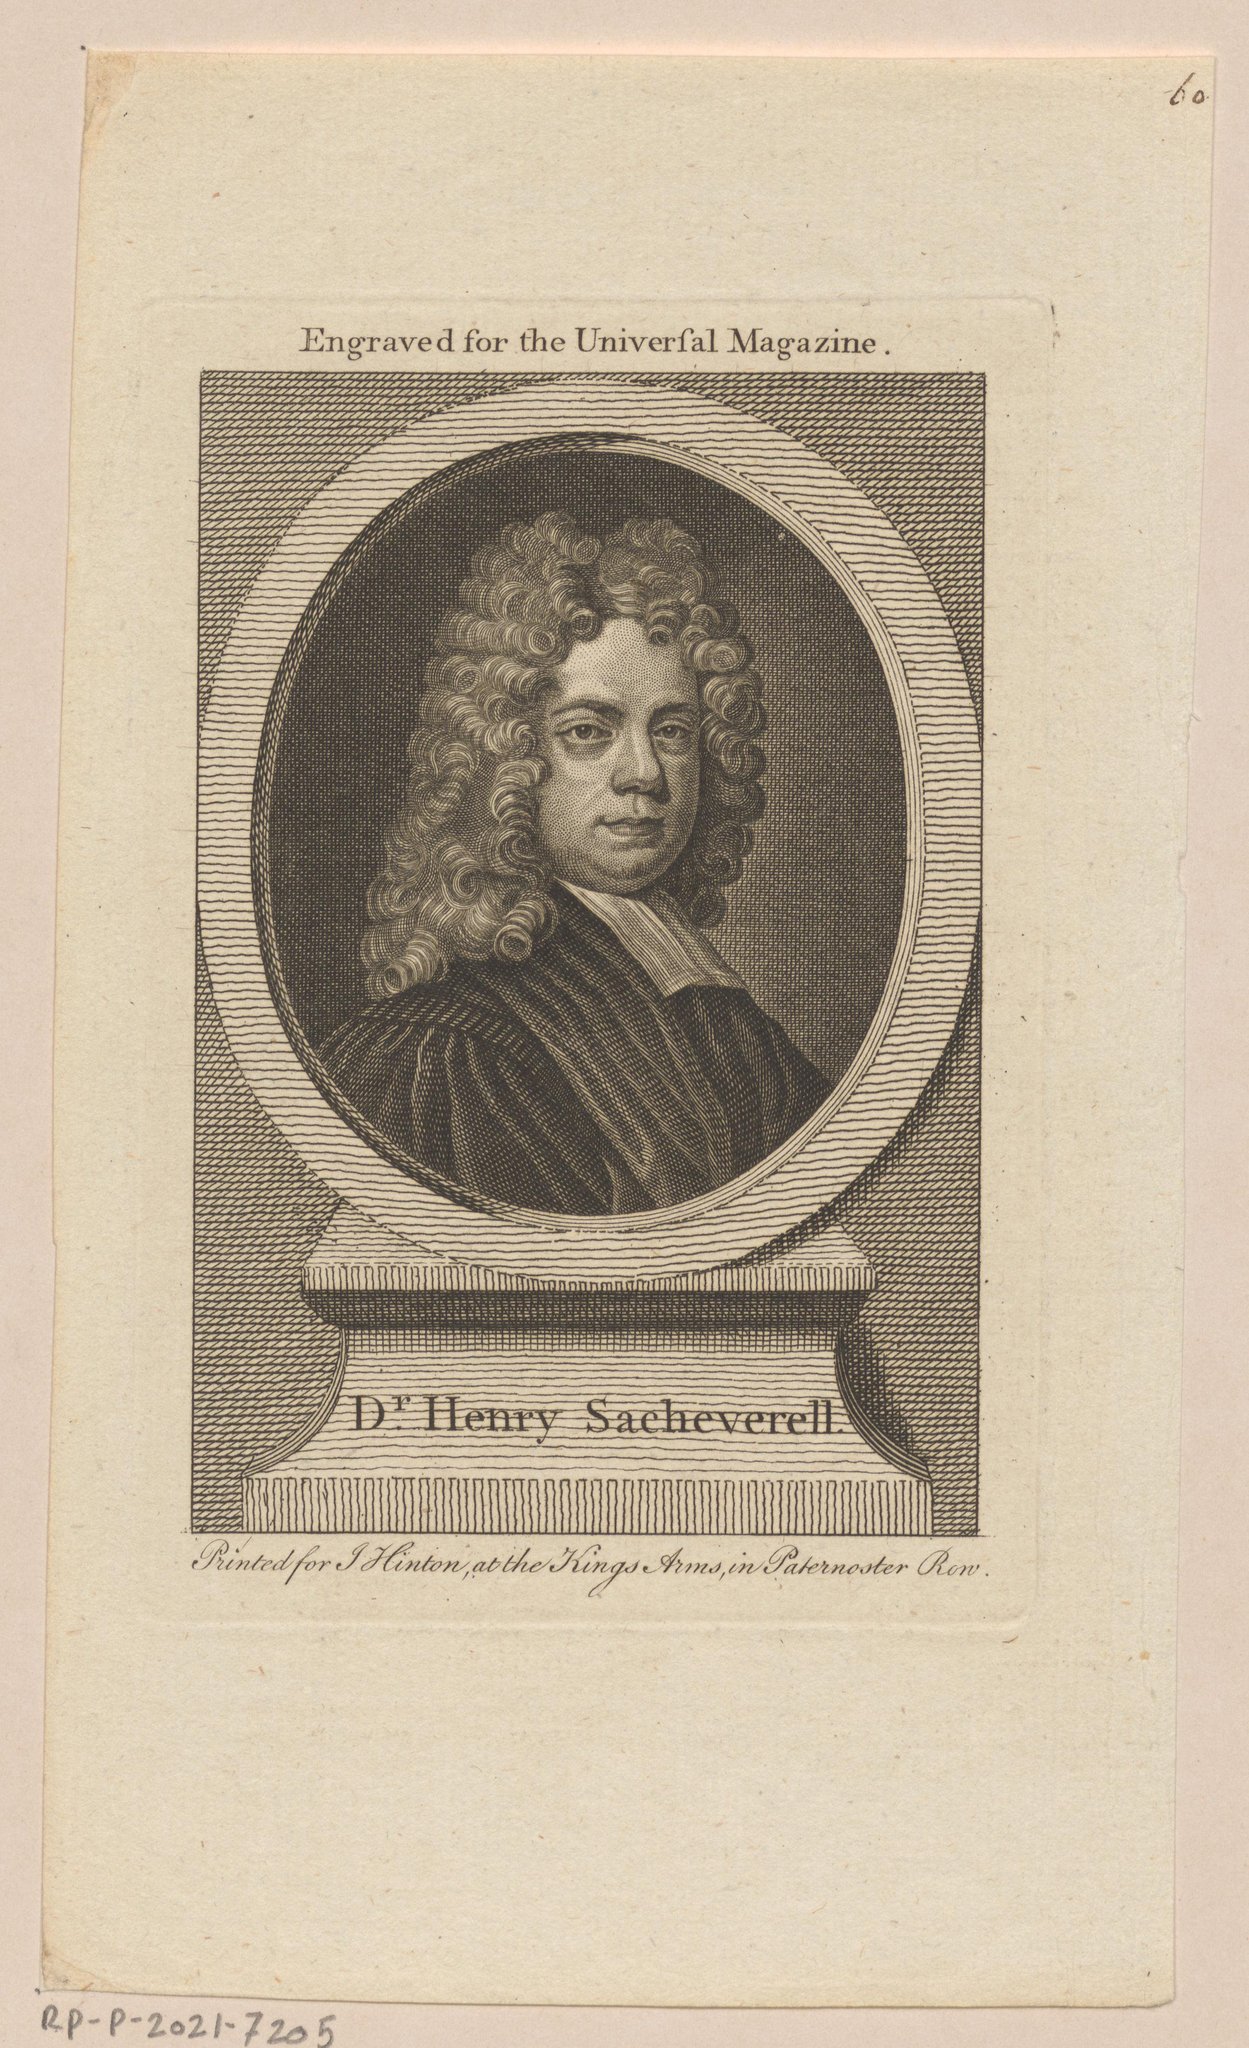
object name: print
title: Portret van Henry Sacheverell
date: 1747-1781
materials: paper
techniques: etching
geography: london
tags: london, historical persons, functionaries and dignitaries ~ episcopal protestant churches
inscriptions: inscription: ‘60’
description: De prent is waarschijnlijk gebruikt in een uitgave van de Universal Magazine.